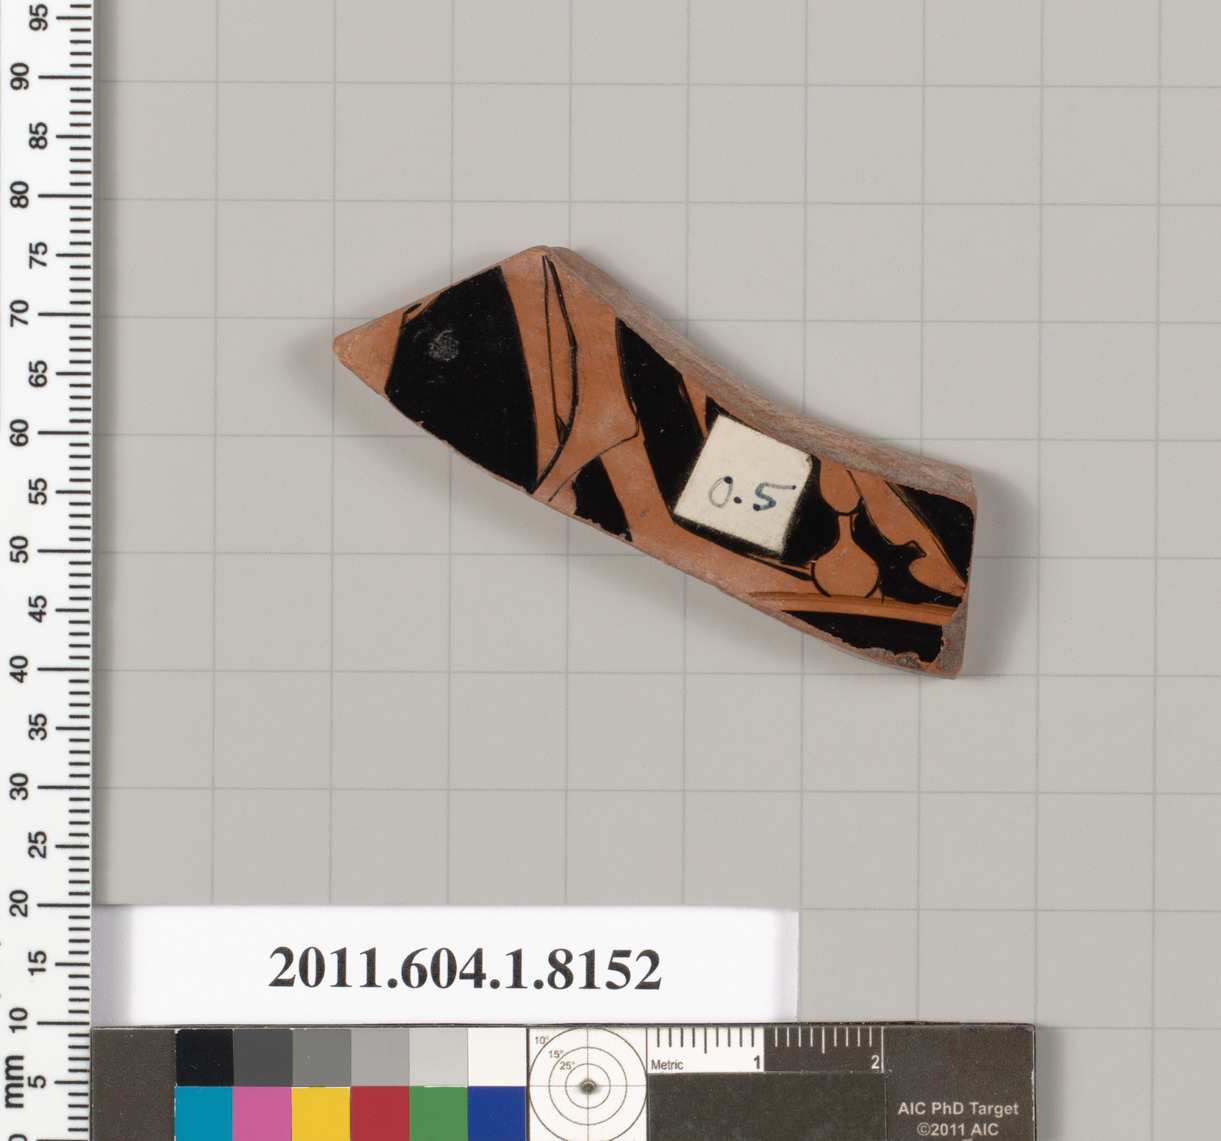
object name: kylix fragment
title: Terracotta fragment of a kylix (drinking cup)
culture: greek, attic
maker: nikosthenes painter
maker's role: artist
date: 500-480 BCE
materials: terracotta